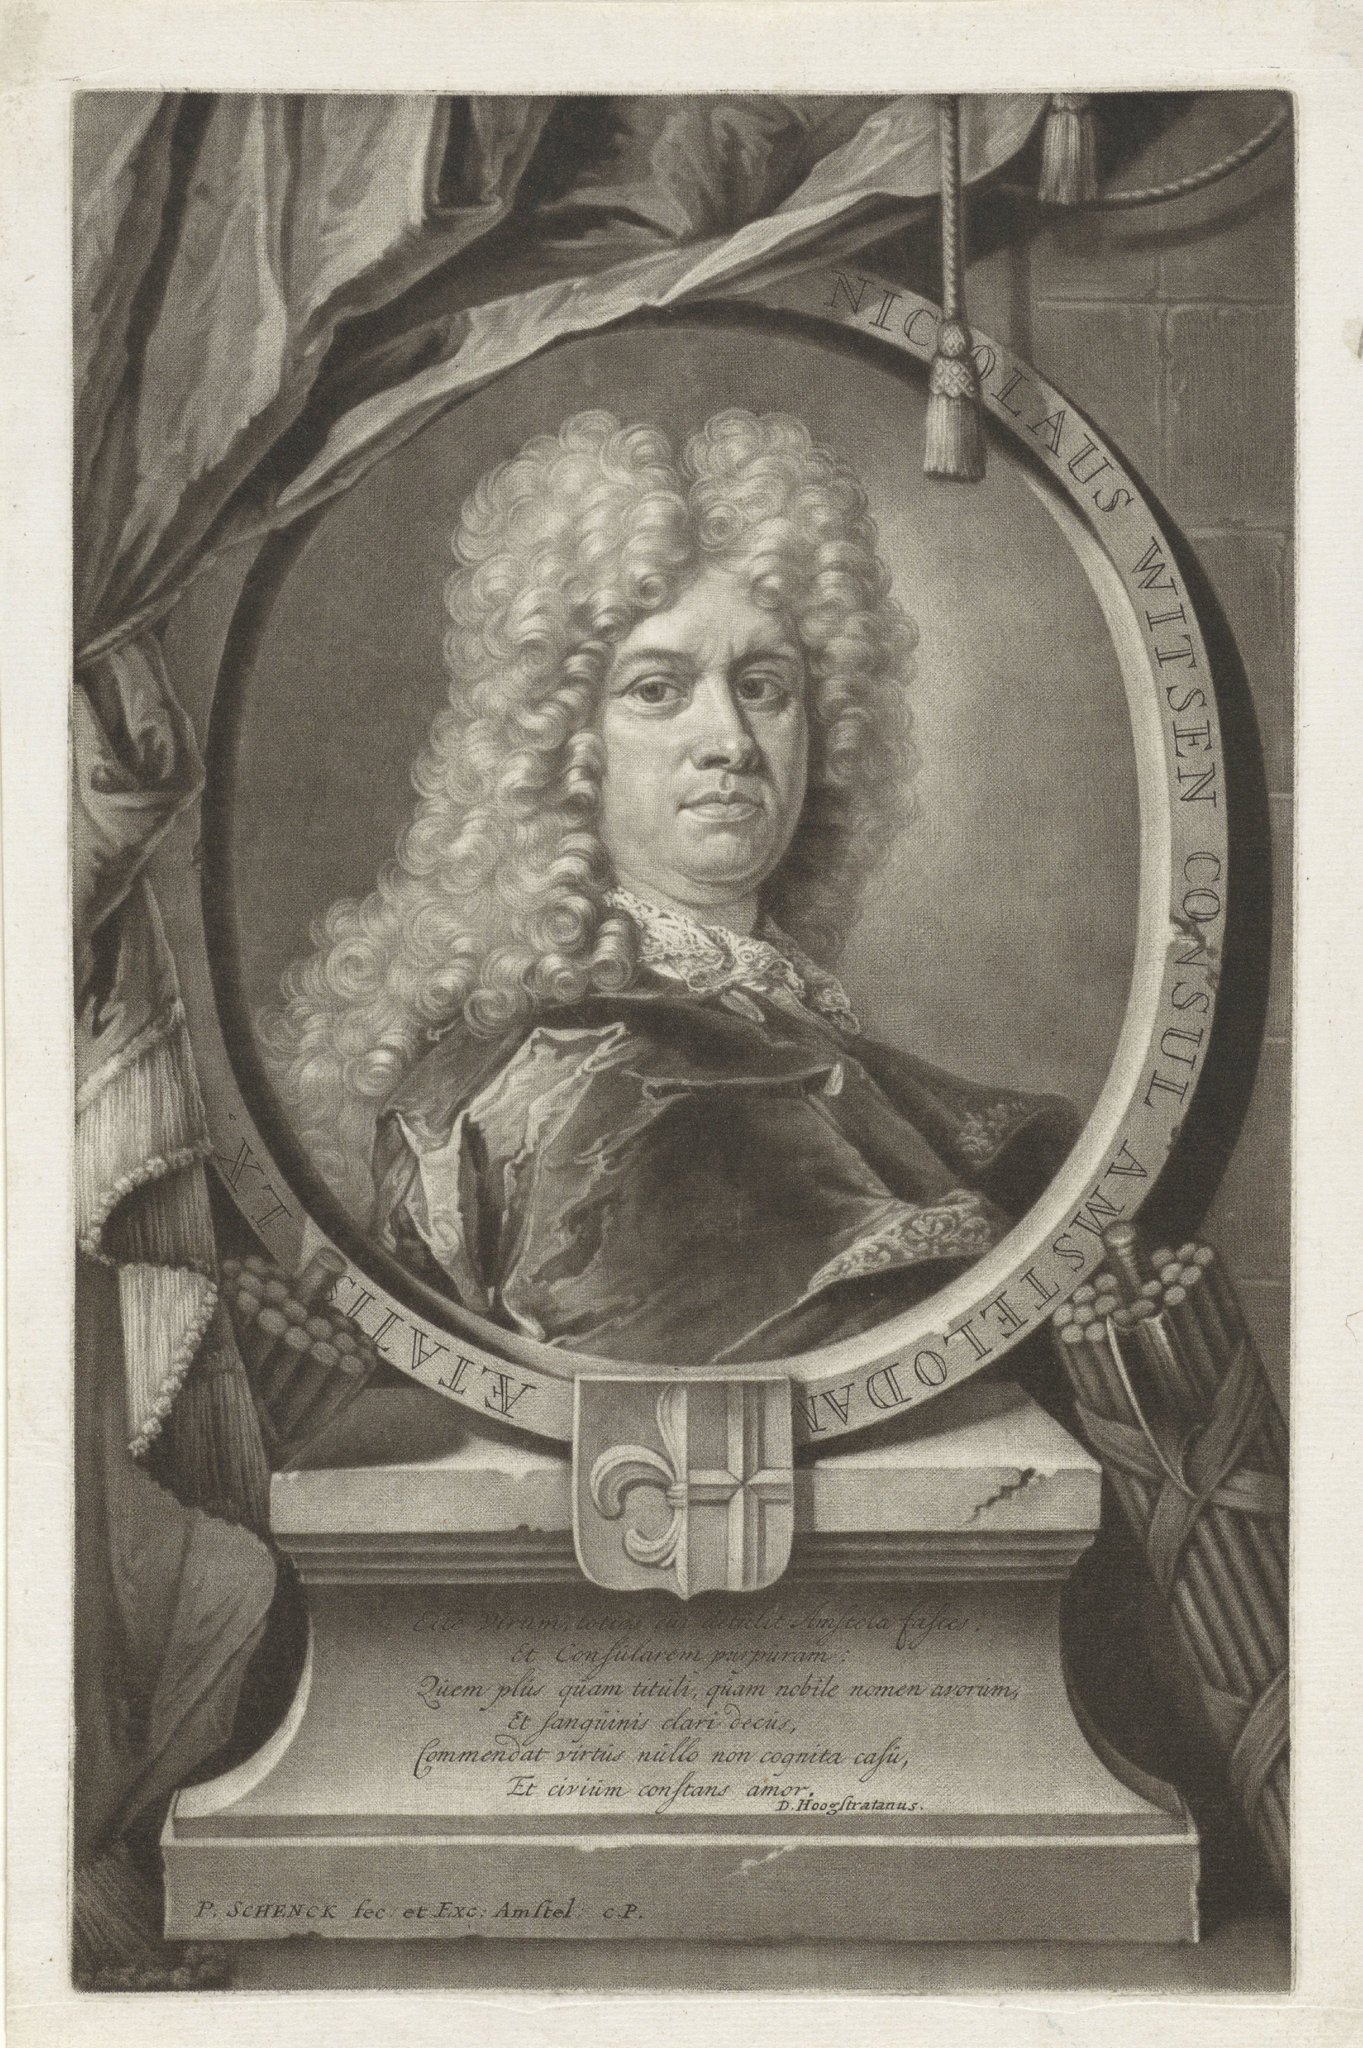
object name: print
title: Portret van Nicolaes Cornelisz. Witsen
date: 1670-1713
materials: paper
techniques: engraving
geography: amsterdam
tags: print maker, mayor, nicolaes cornelisz. witsen, wig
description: De prentmaker, cartograaf en burgemeester van Amsterdam, Nicolaes Cornelisz. Witsen op 60-jarige leeftijd.